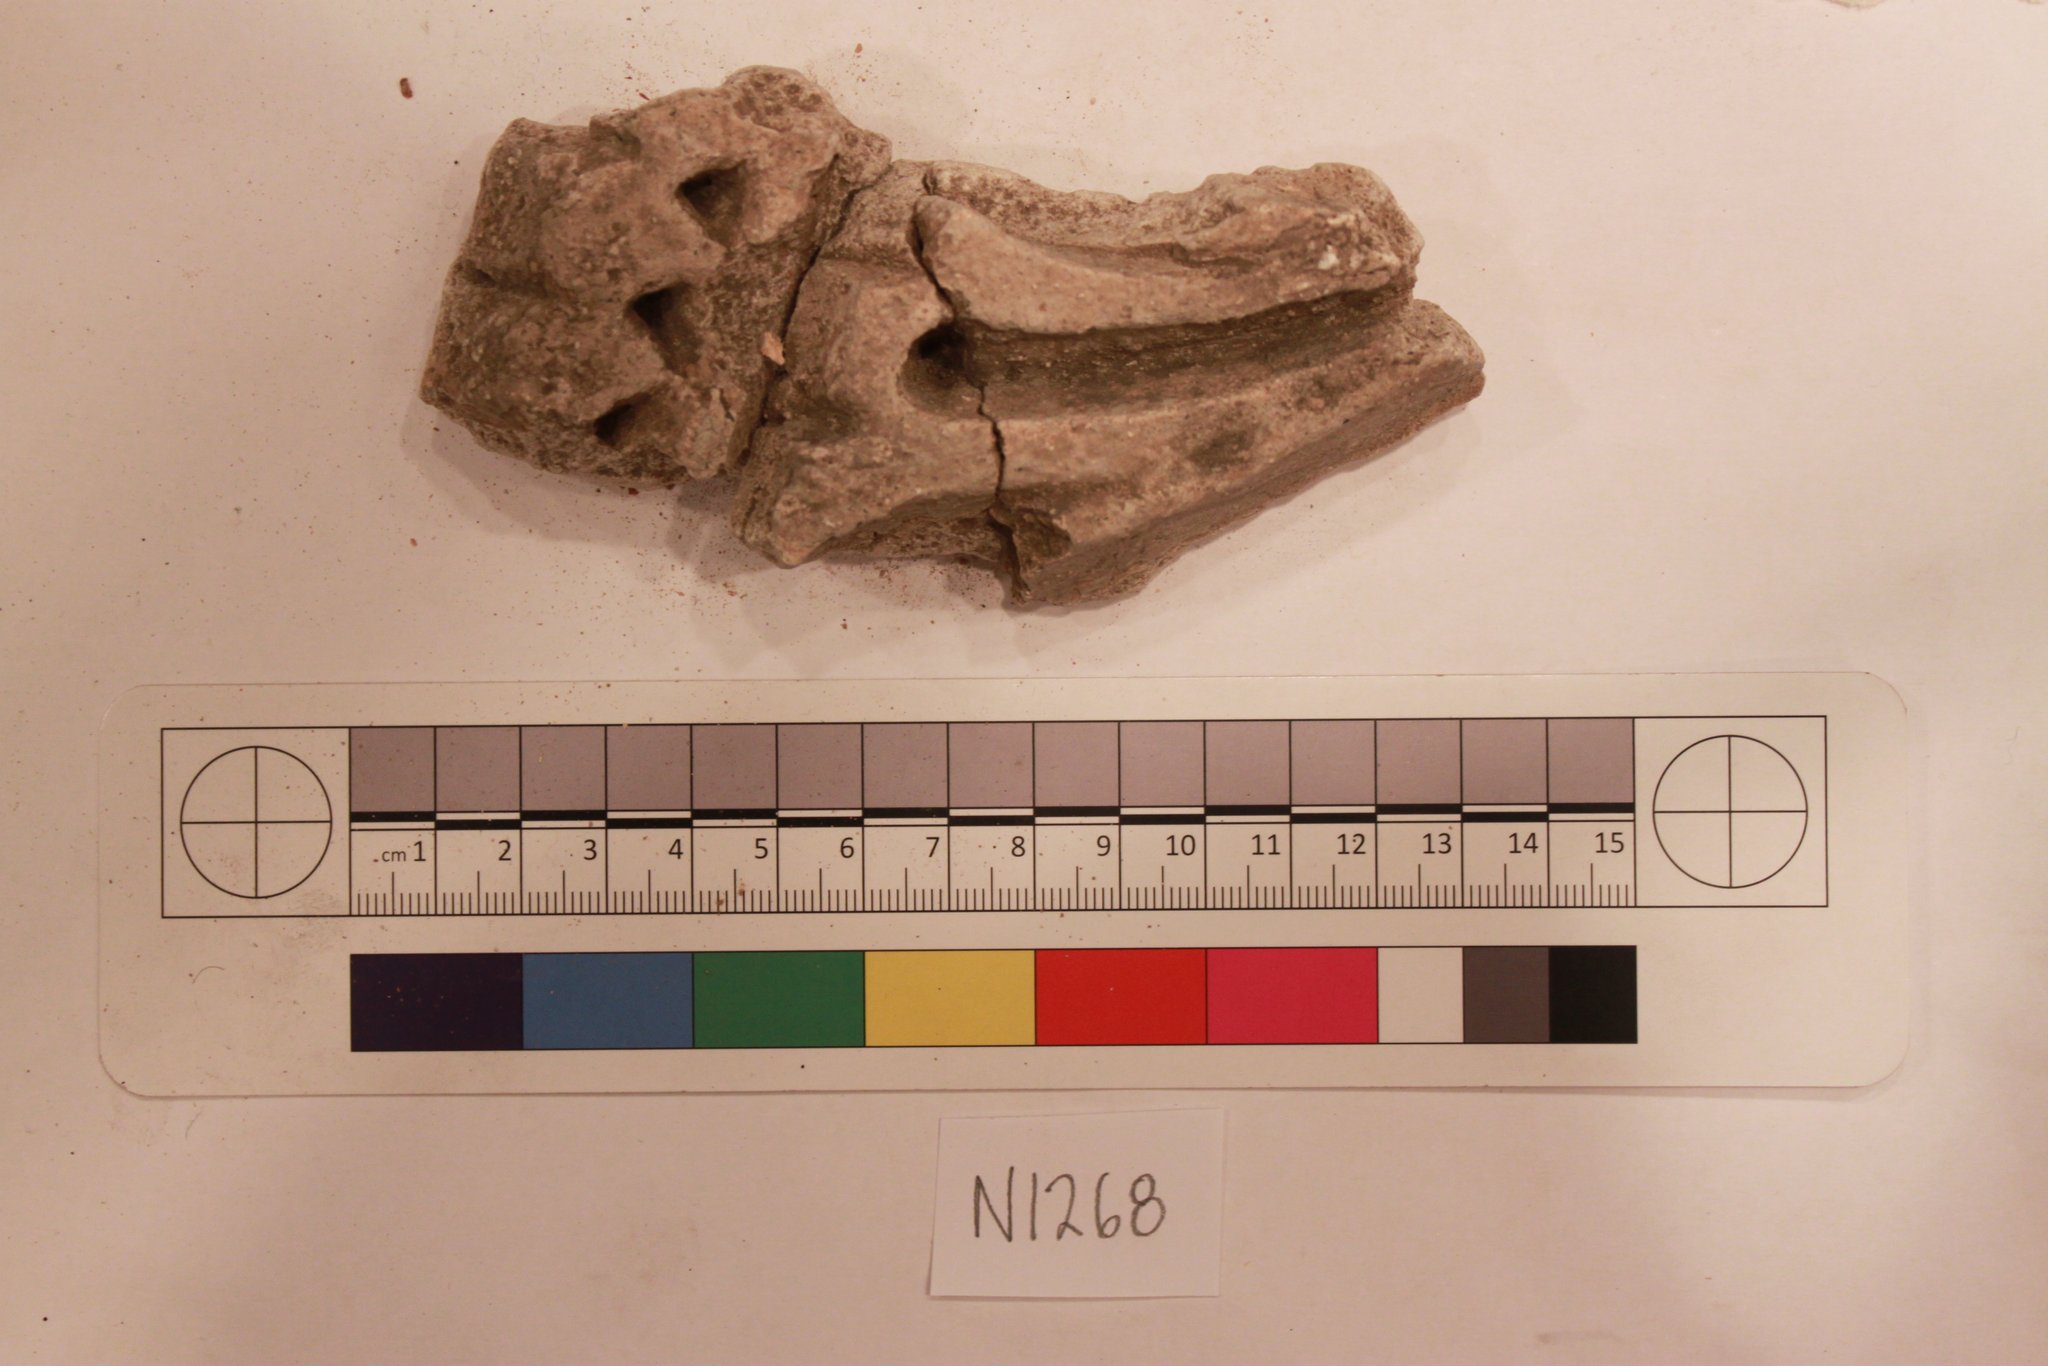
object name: fragment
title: Stucco Fragment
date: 701-1200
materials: plaster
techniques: carving, painting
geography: iran